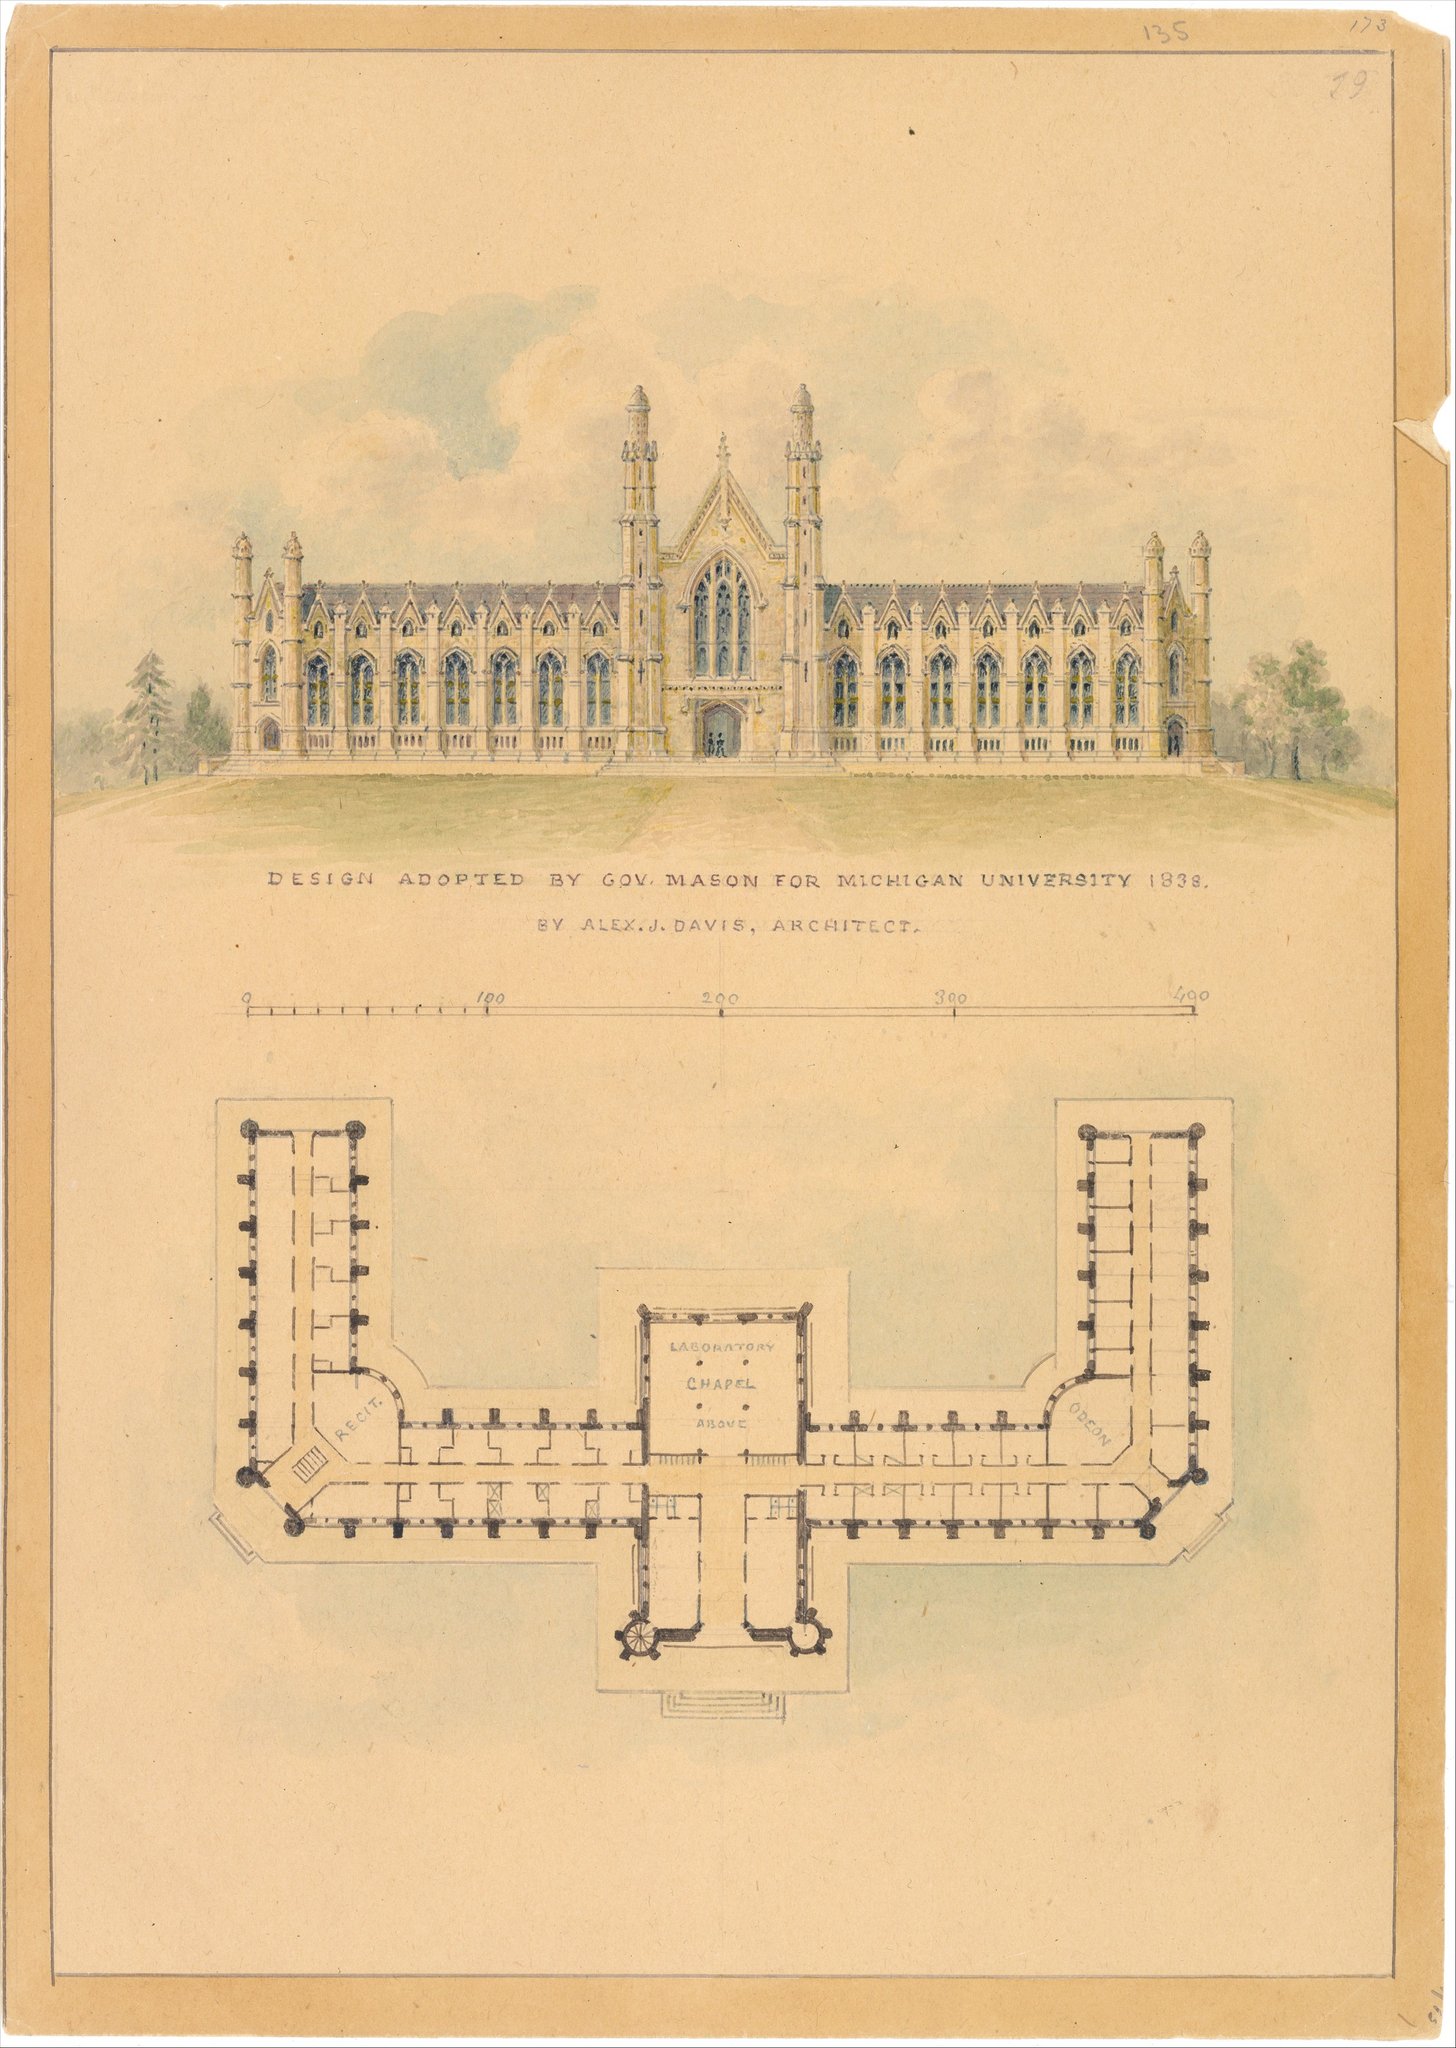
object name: drawing ornament architecture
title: Design Adopted by Governor Mason for University of Michigan (elevation and plan)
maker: alexander jackson davis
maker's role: artist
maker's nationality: american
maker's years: 1803-1892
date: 1838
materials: ink, watercolor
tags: architecture,schools